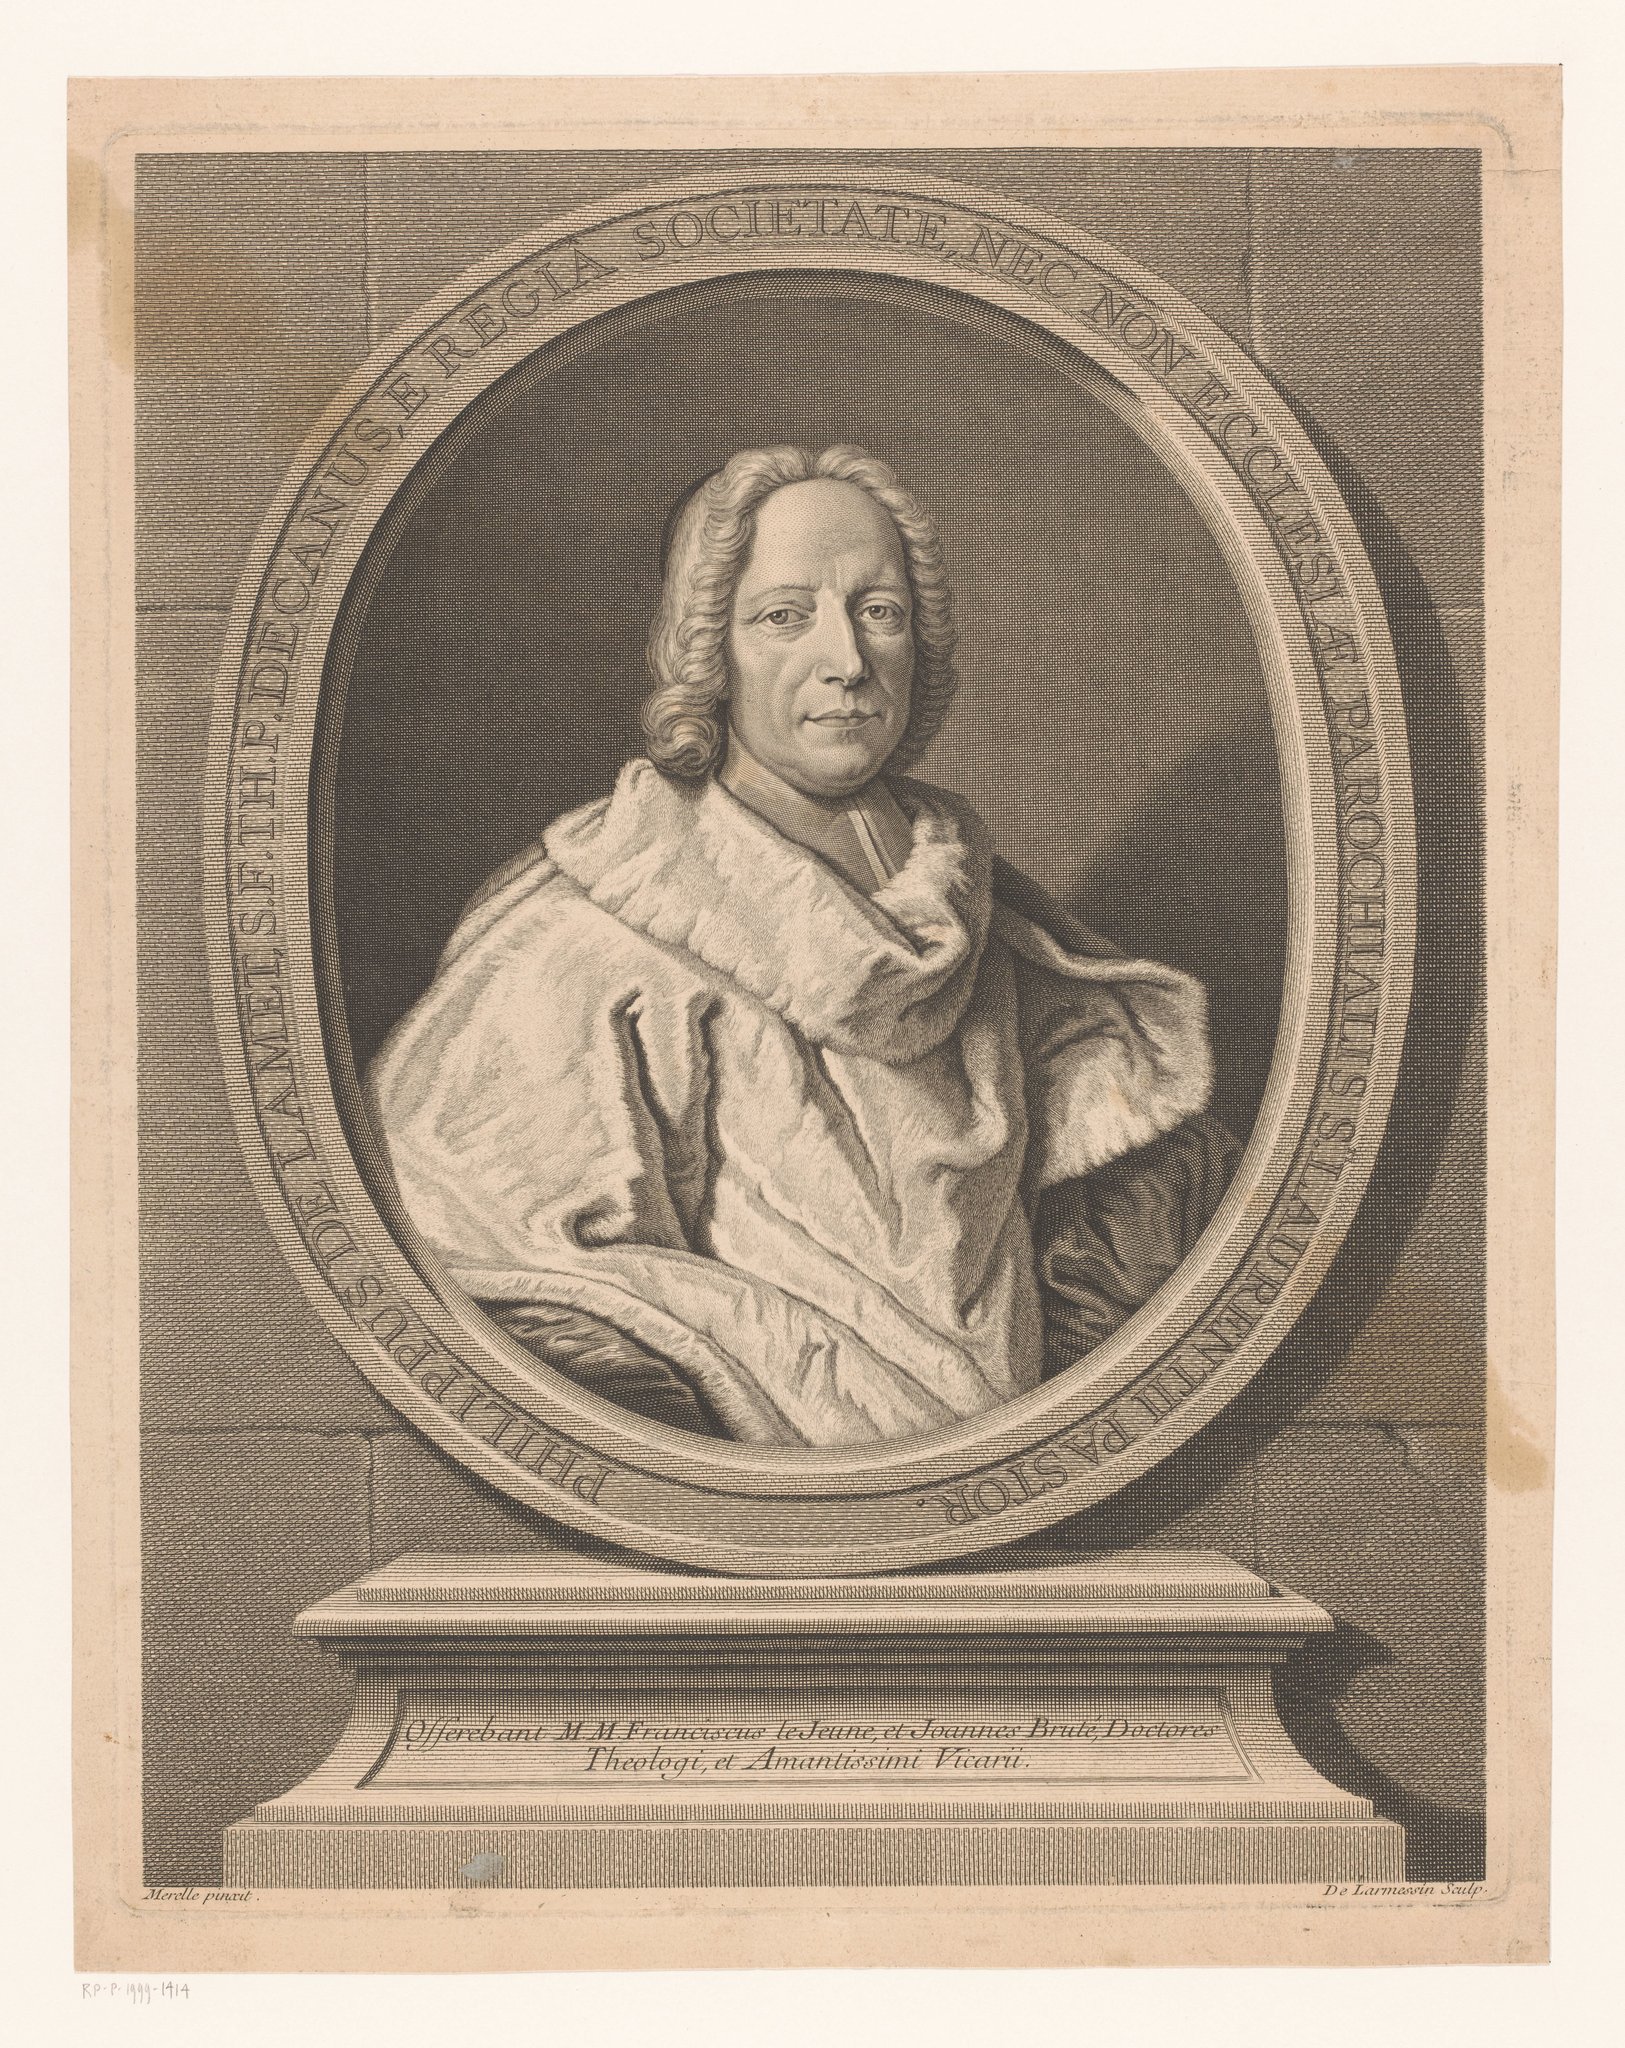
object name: print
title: Portret van Philippus de Lamet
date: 1694-1755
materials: paper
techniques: engraving, etching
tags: hierarchy of jurisdiction ~ roman catholic church, historical persons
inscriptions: collector's mark: Lugt 2760, collector's mark: Lugt 2228